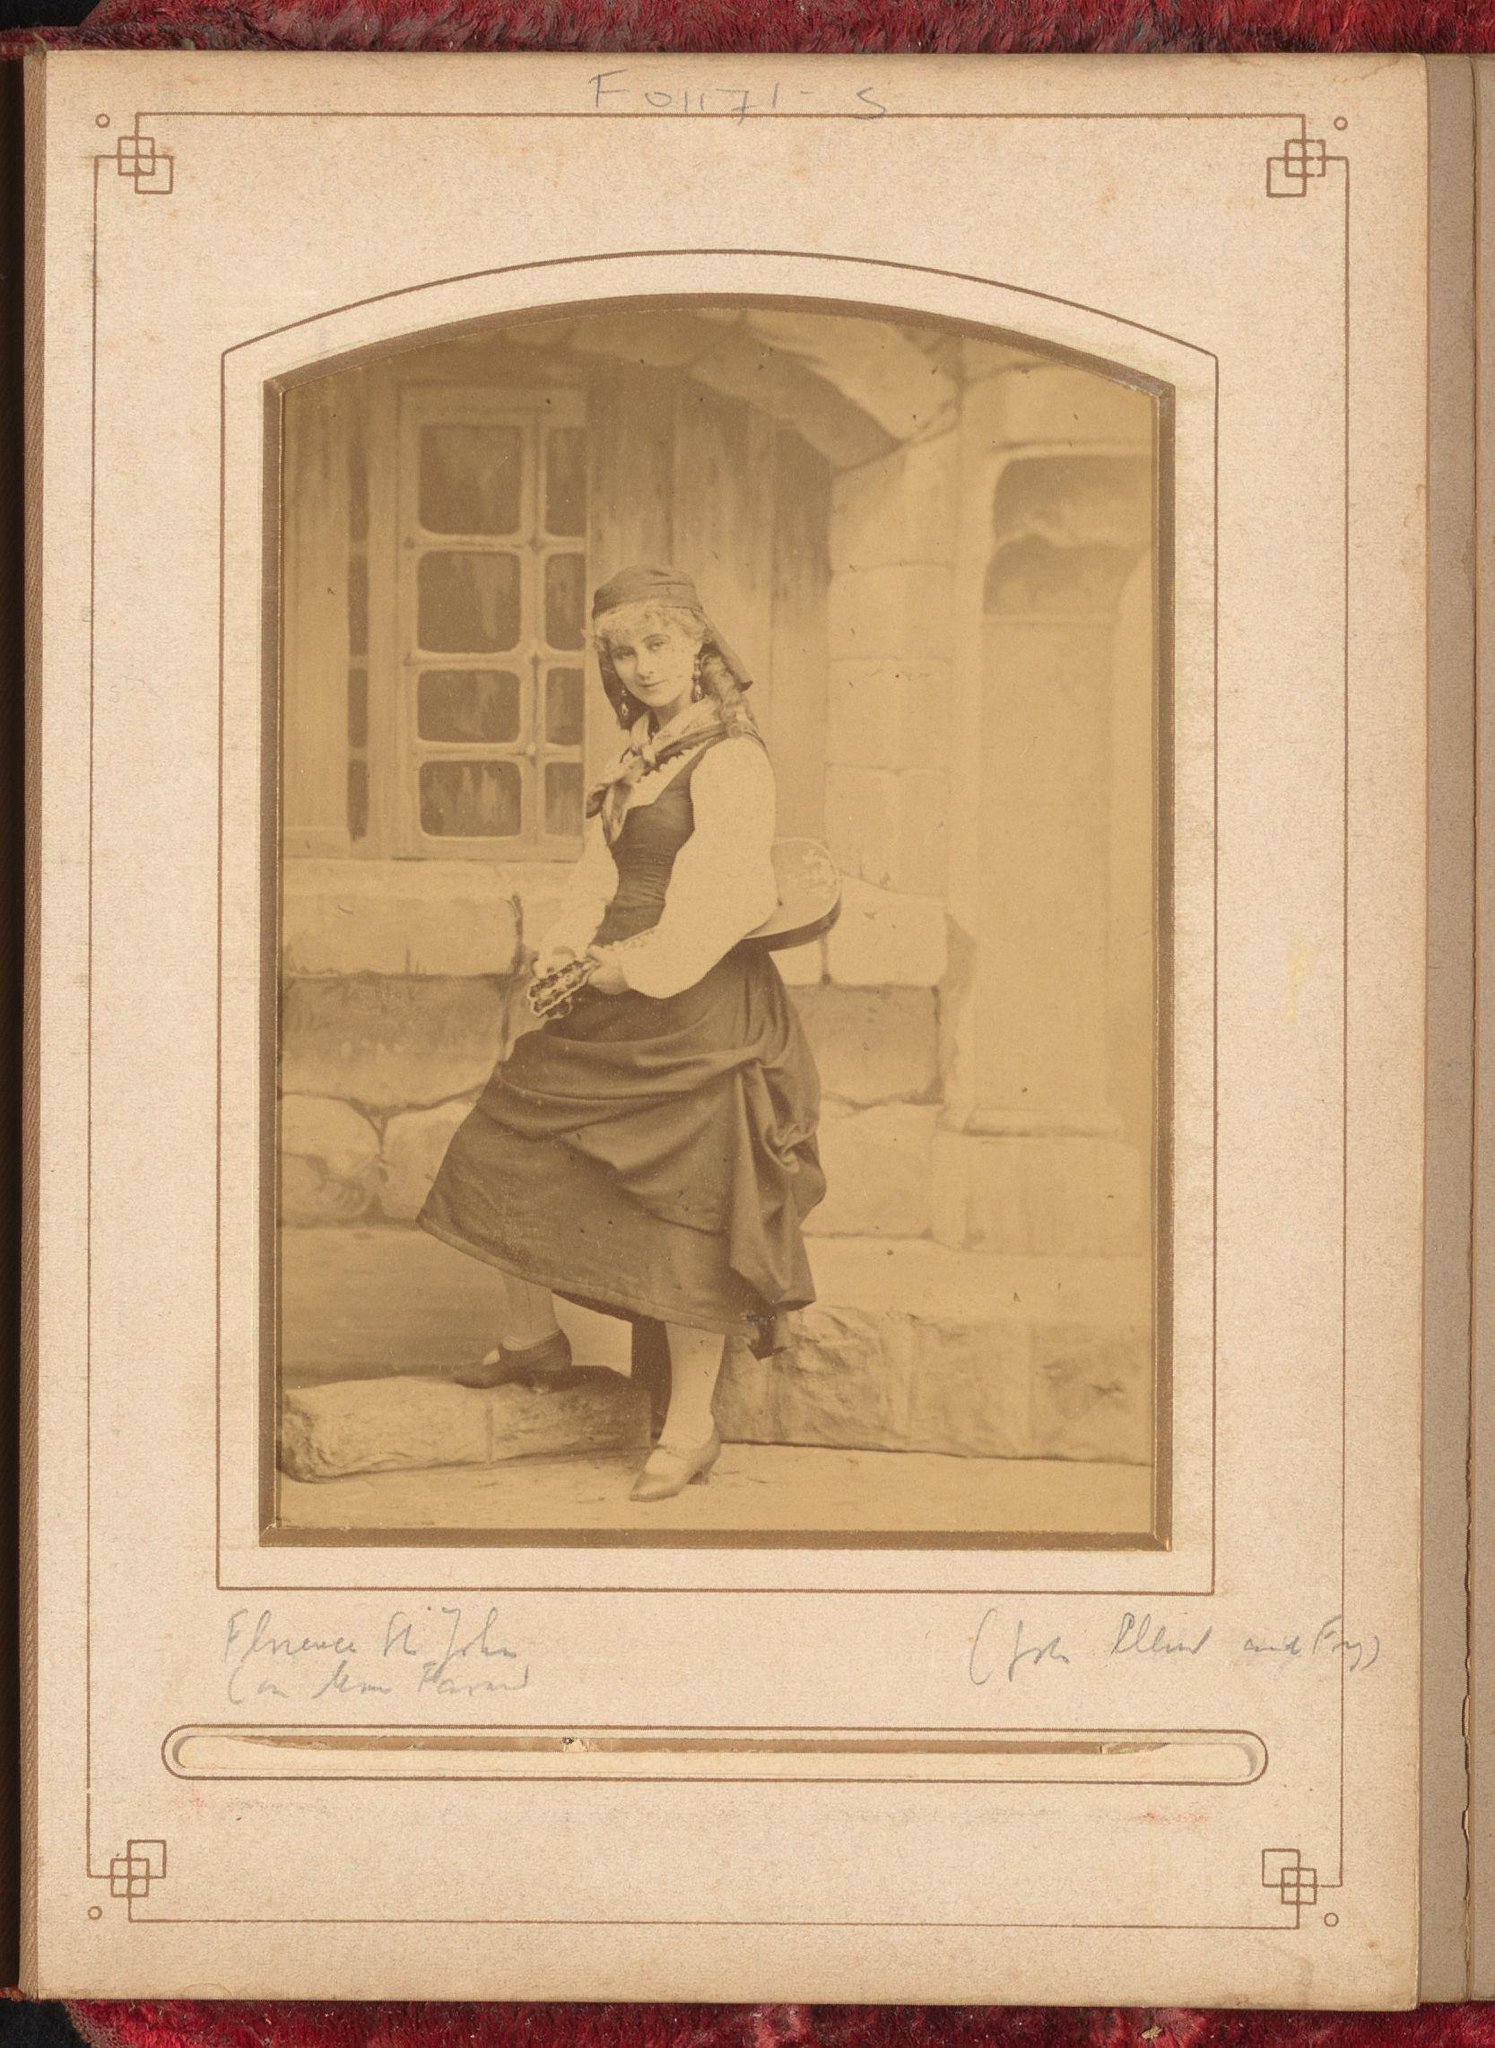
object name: photograph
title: Miss Florence St.John in Madame Favart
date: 1870-1900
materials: cardboard, photographic support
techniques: albumen print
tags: adult woman, stage costume, portrait of actor, actress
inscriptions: name: ‘Elliot&Fry Copyright 55&56, Baker St. London.W’, inscription: ‘Elliot and Fry/ Photographers/ 55&56, Baker St. London/ W.’, retailer's mark: ‘R. van der Sprong Hz./ Kunsthndel/ Utrecht’